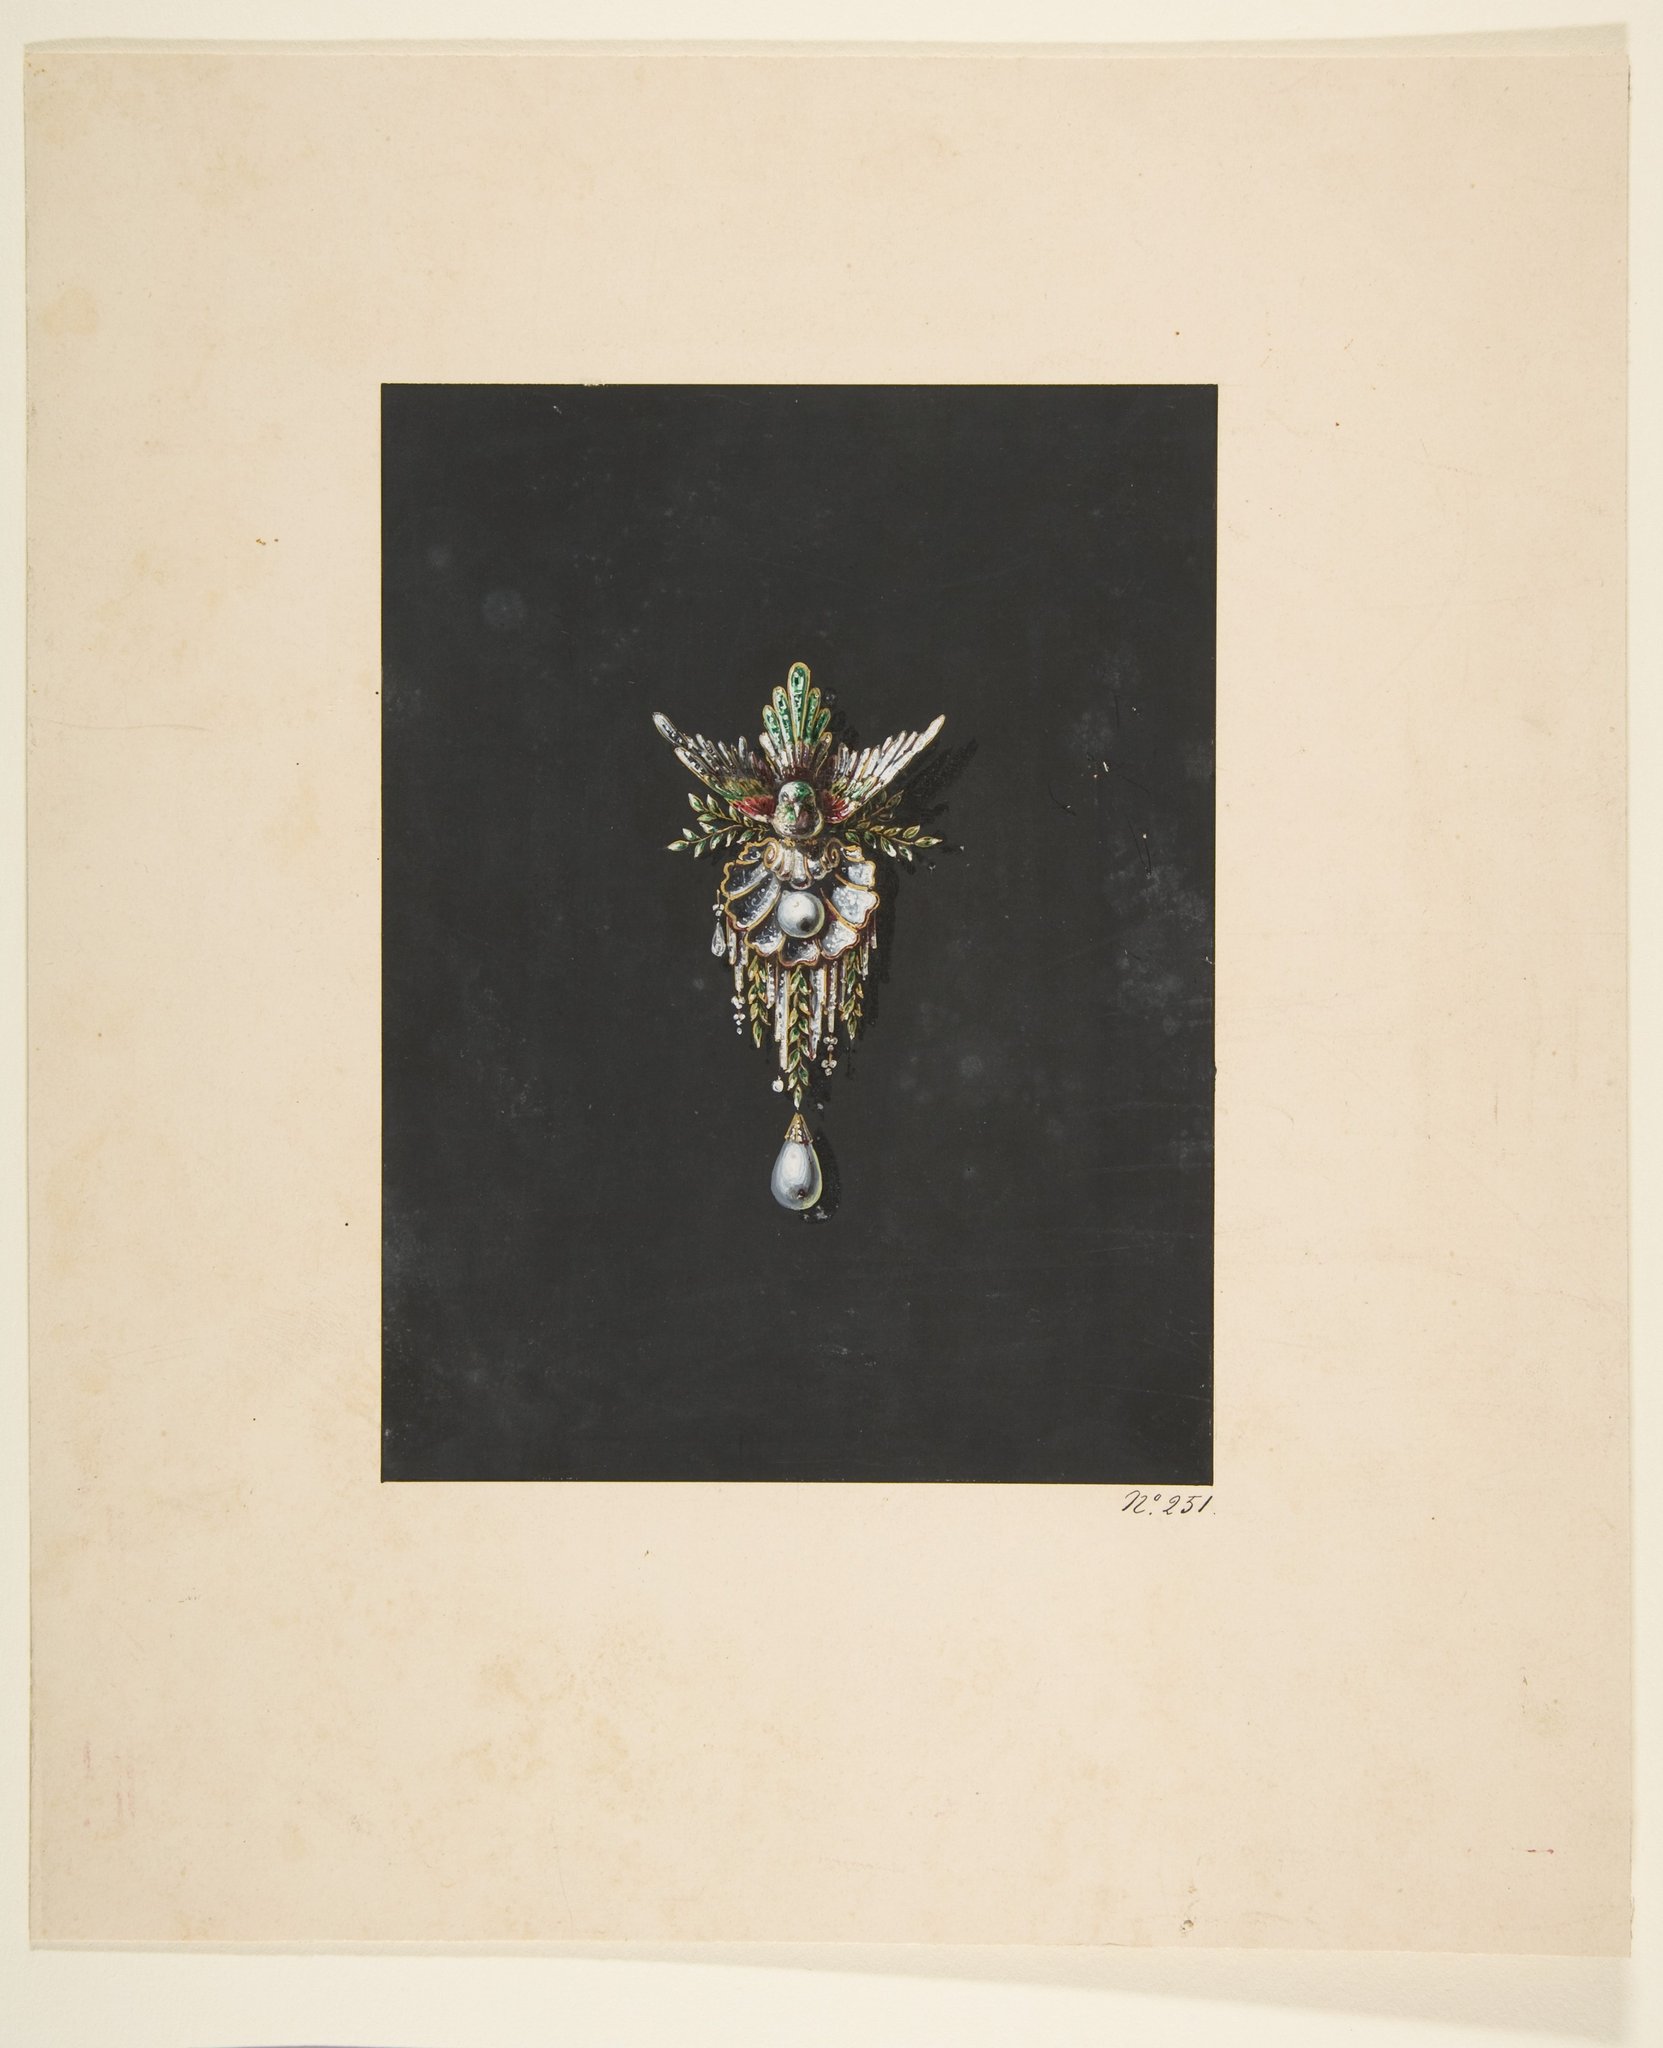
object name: drawing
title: Design for a brooch with bird motif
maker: anonymous, french, 19th century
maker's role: artist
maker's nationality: french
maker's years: 1800-1900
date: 1801-1900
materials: cardboard, gouache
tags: birds,jewelry